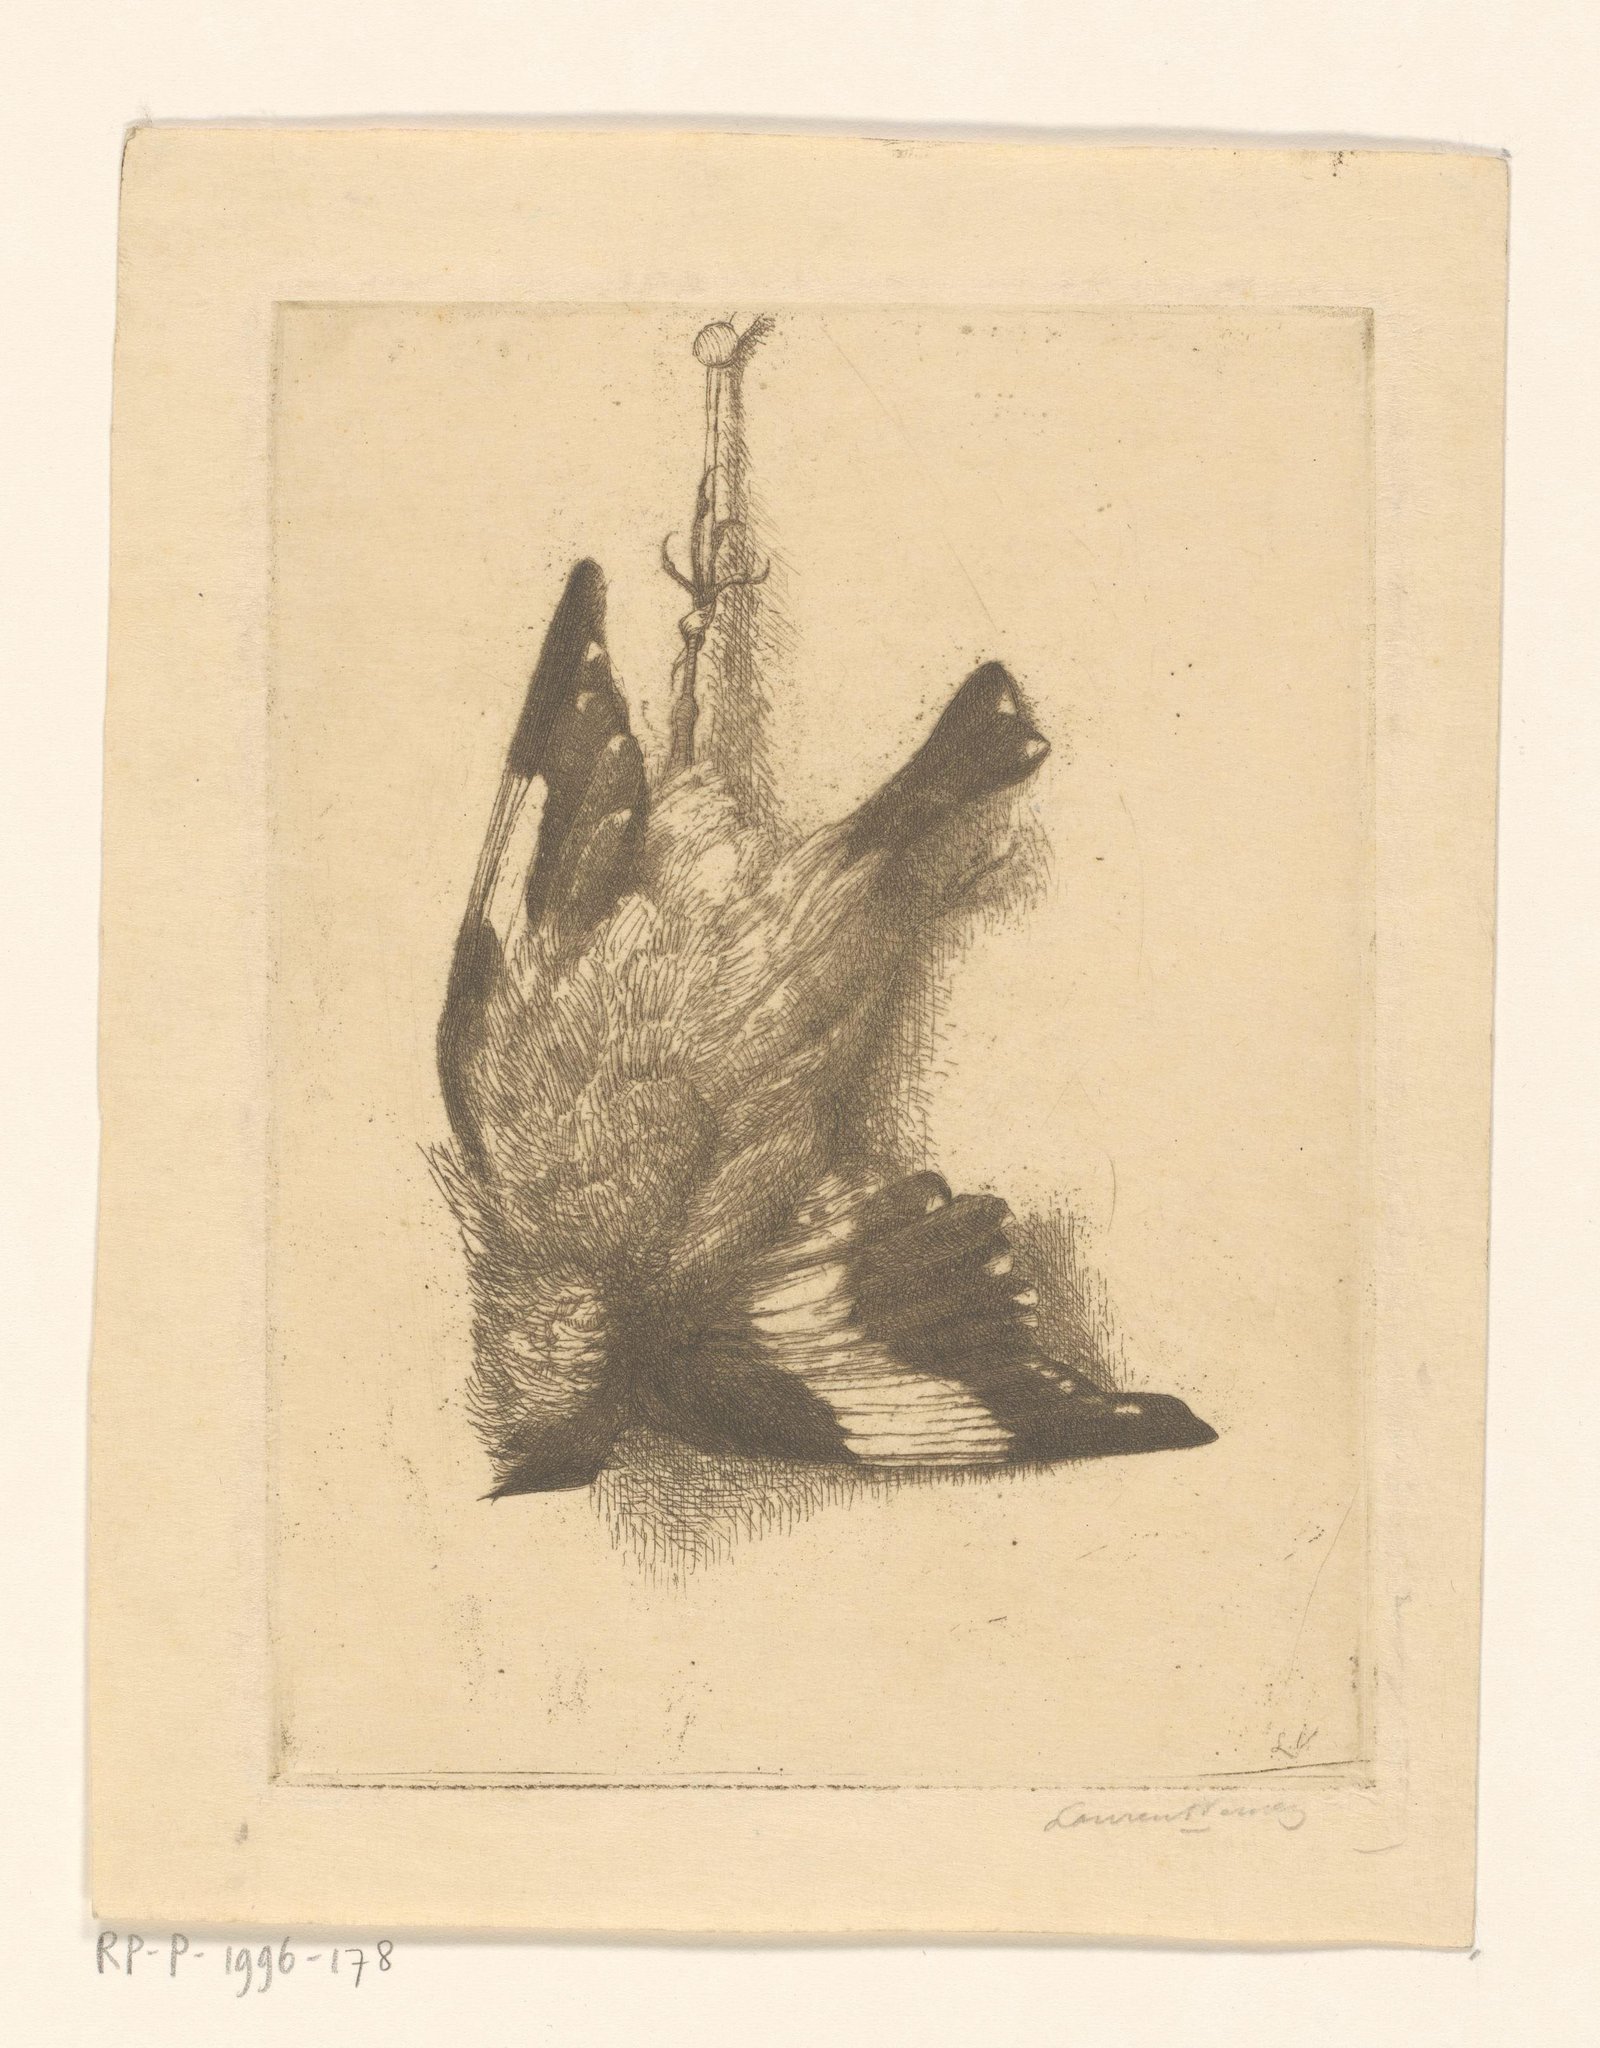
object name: print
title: Dode vogel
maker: laurent verwey van udenhout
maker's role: print maker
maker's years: 1884-1913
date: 1894-1913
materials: paper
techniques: drypoint, etching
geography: netherlands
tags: birds (+ disease and death of animal(s))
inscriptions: inscription: ‘niet [...]’, collector's mark: Lugt 2228